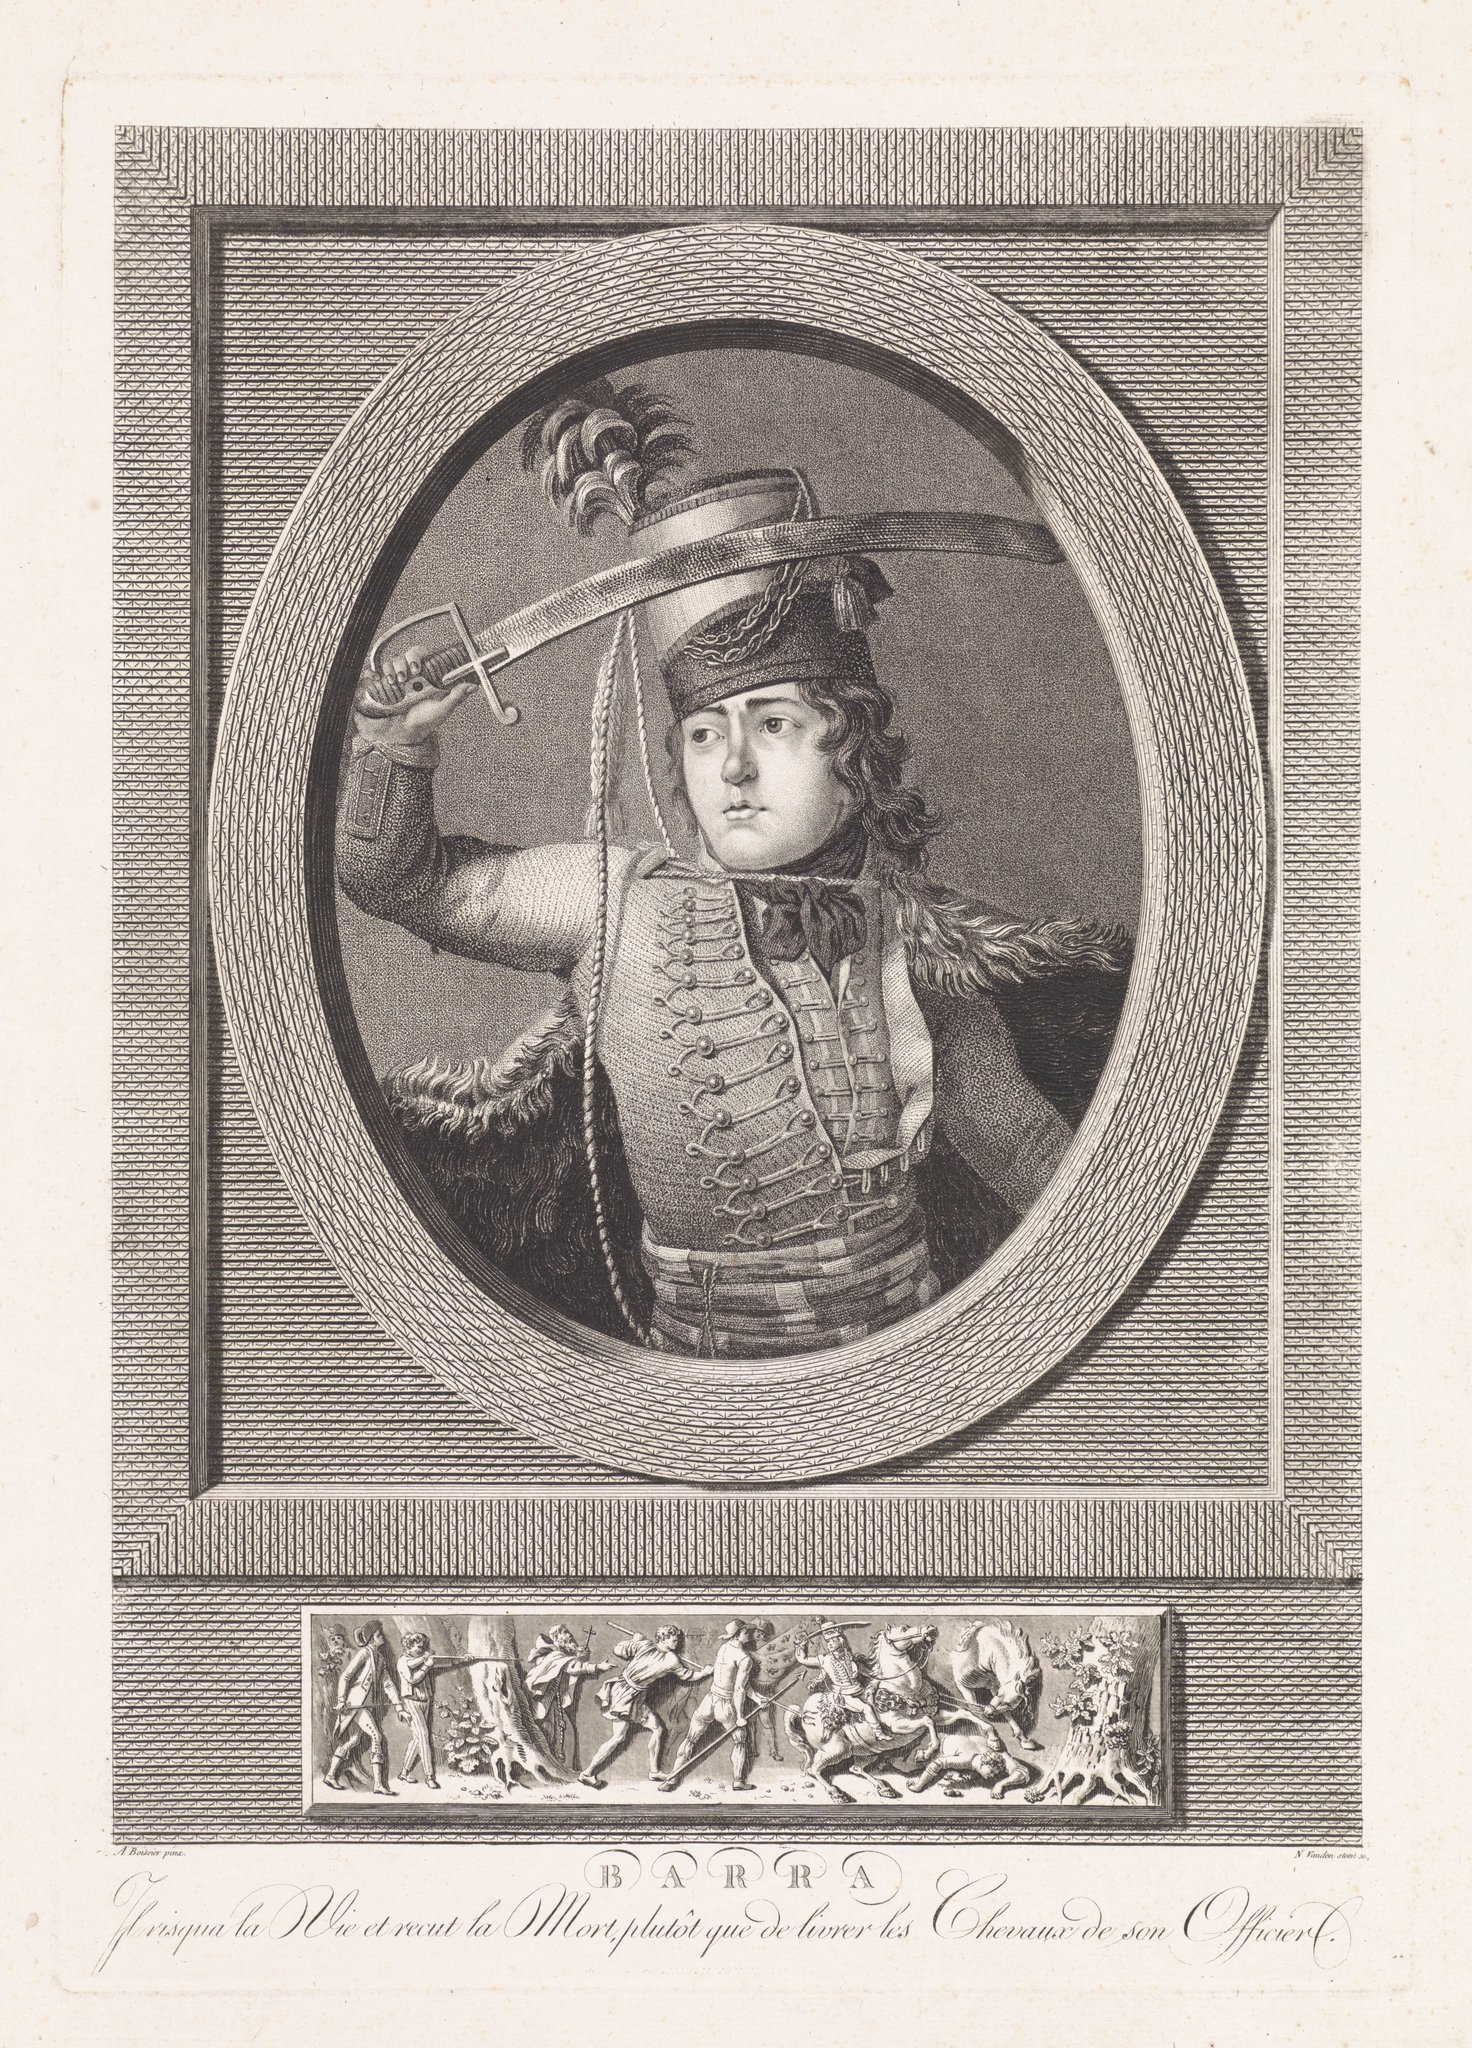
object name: print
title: Portret van de huzaar Barra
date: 1700-1800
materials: paper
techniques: engraving, etching, roulette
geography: netherlands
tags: private soldier, the soldier; the soldier's life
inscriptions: collector's mark: Lugt 2228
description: Portret van de huzaar Barra met een sabel geheven in zijn hand. Onder het portret een bas–reliëf met Barra's heldendood. Hij riskeerde zijn leven om de paarden van zijn officier te behouden. Daarbij vond hij de dood.